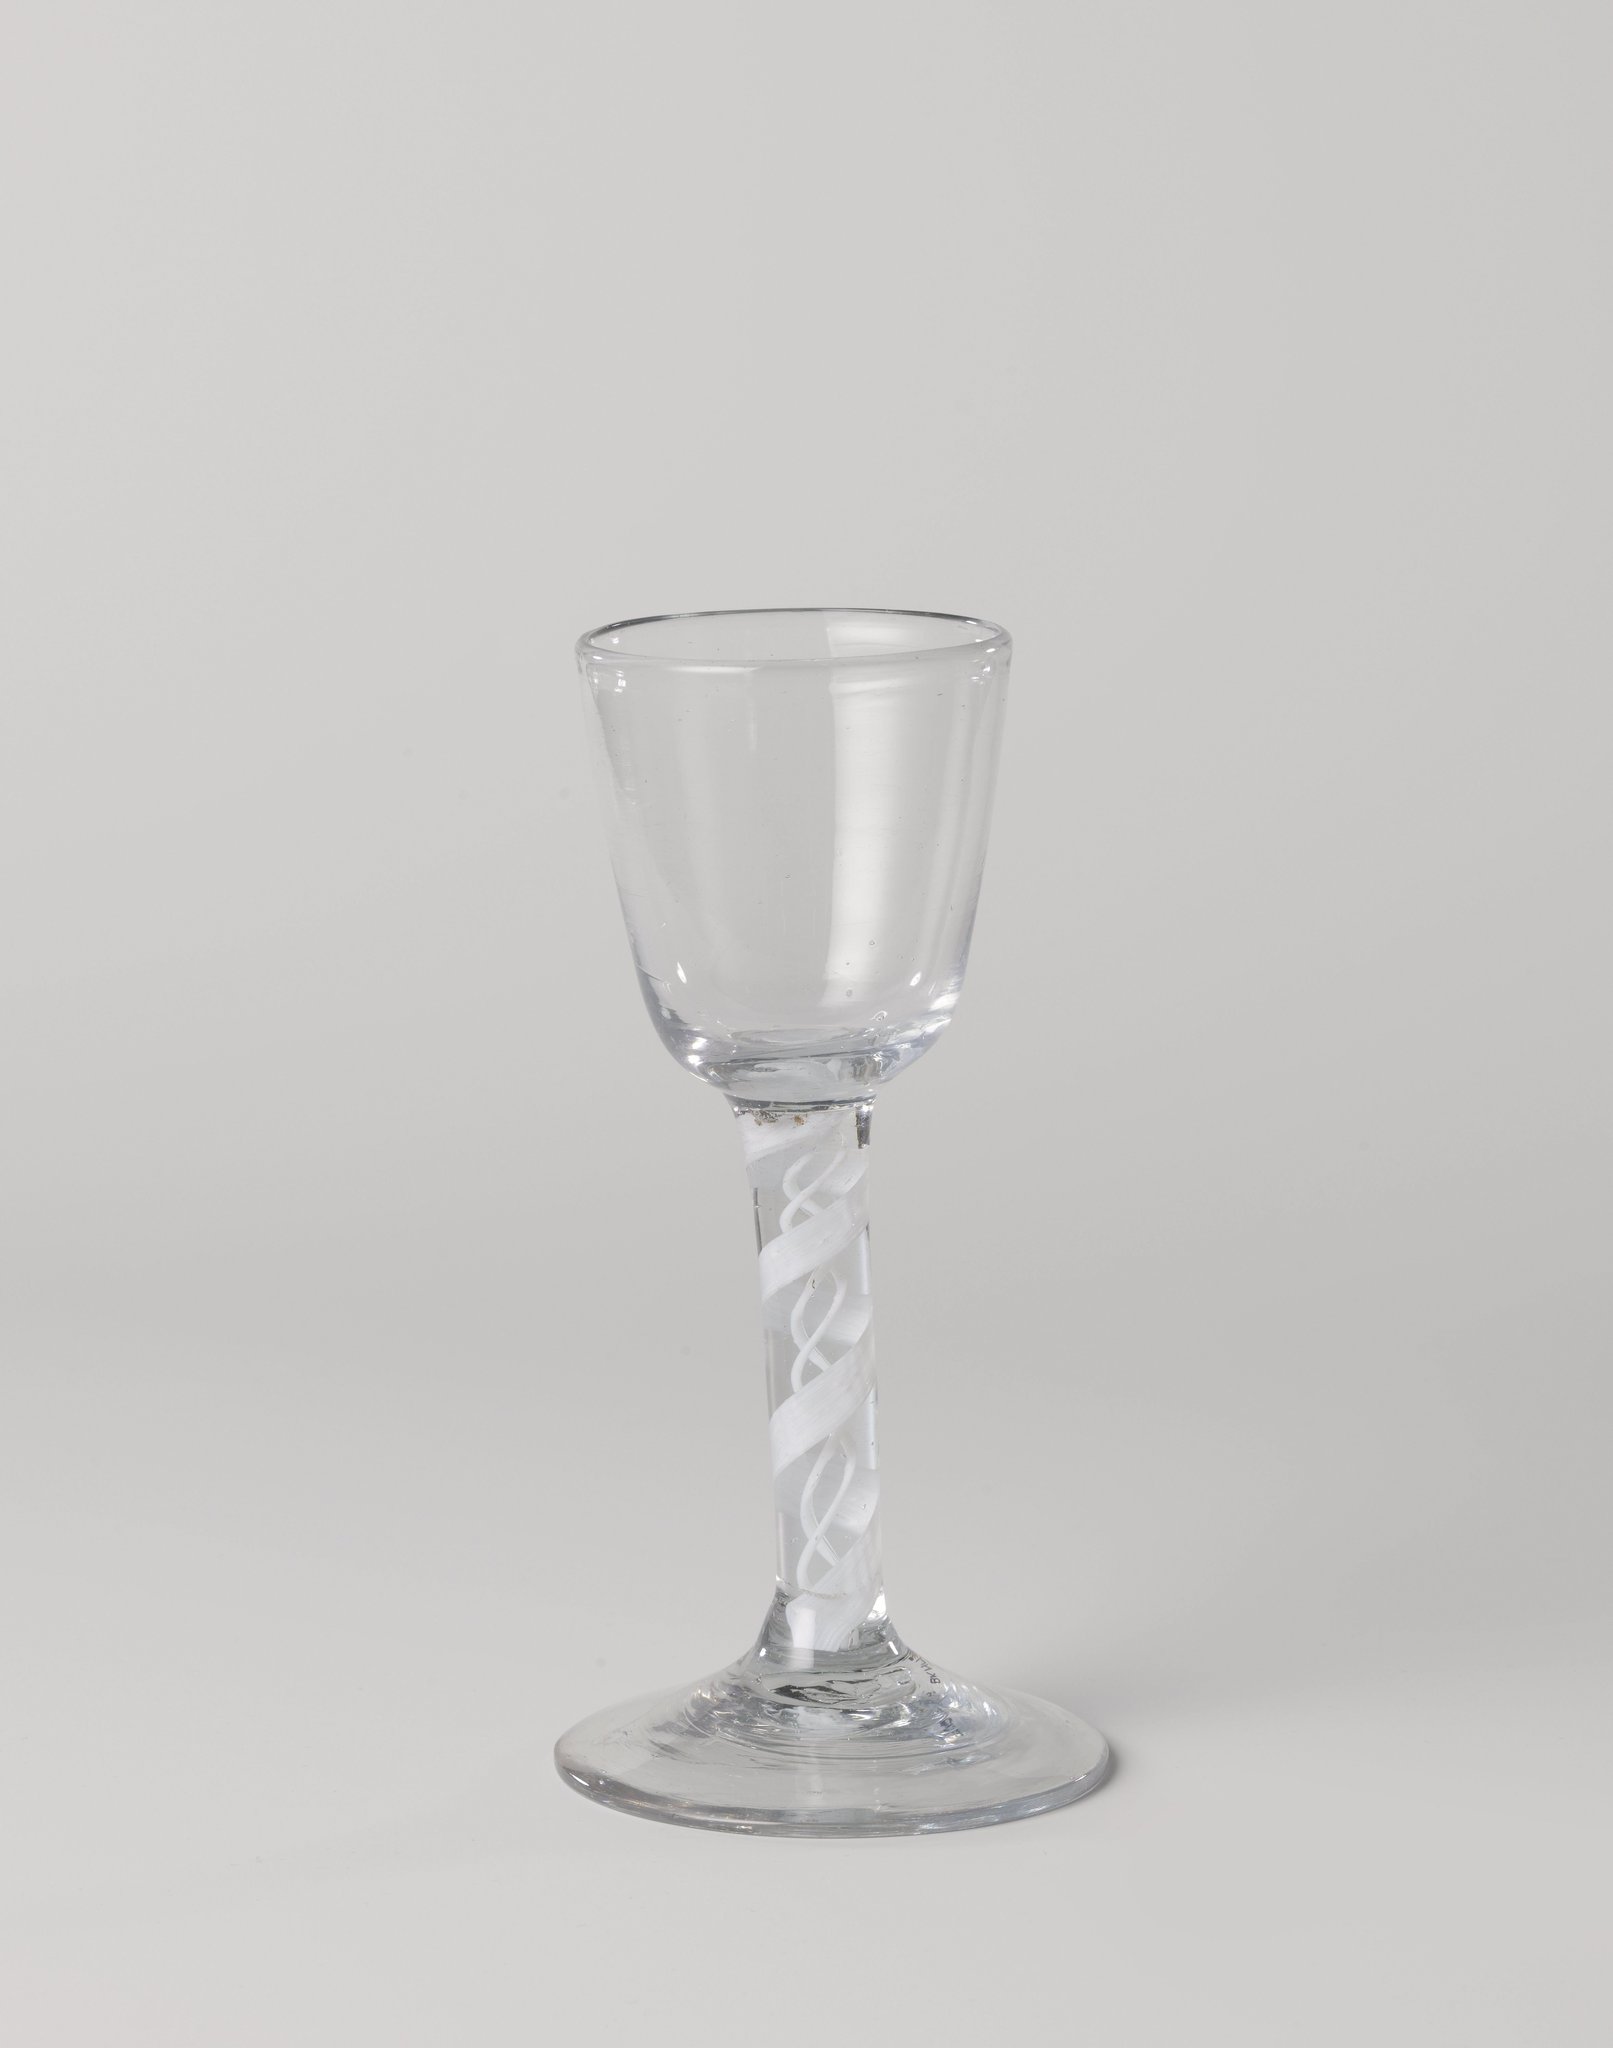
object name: goblet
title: Slingerglas met conische kelk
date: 1750-1774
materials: glass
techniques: glassblowing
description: Slingerglas met conische voet en rechte stam. In de stam een brede opaak witte slinger rond een dubbele spiraal. Conische kelk. Opmerking: aanvankelijk serie van vijf glazen, waarvan er vier zijn afgevoerd.